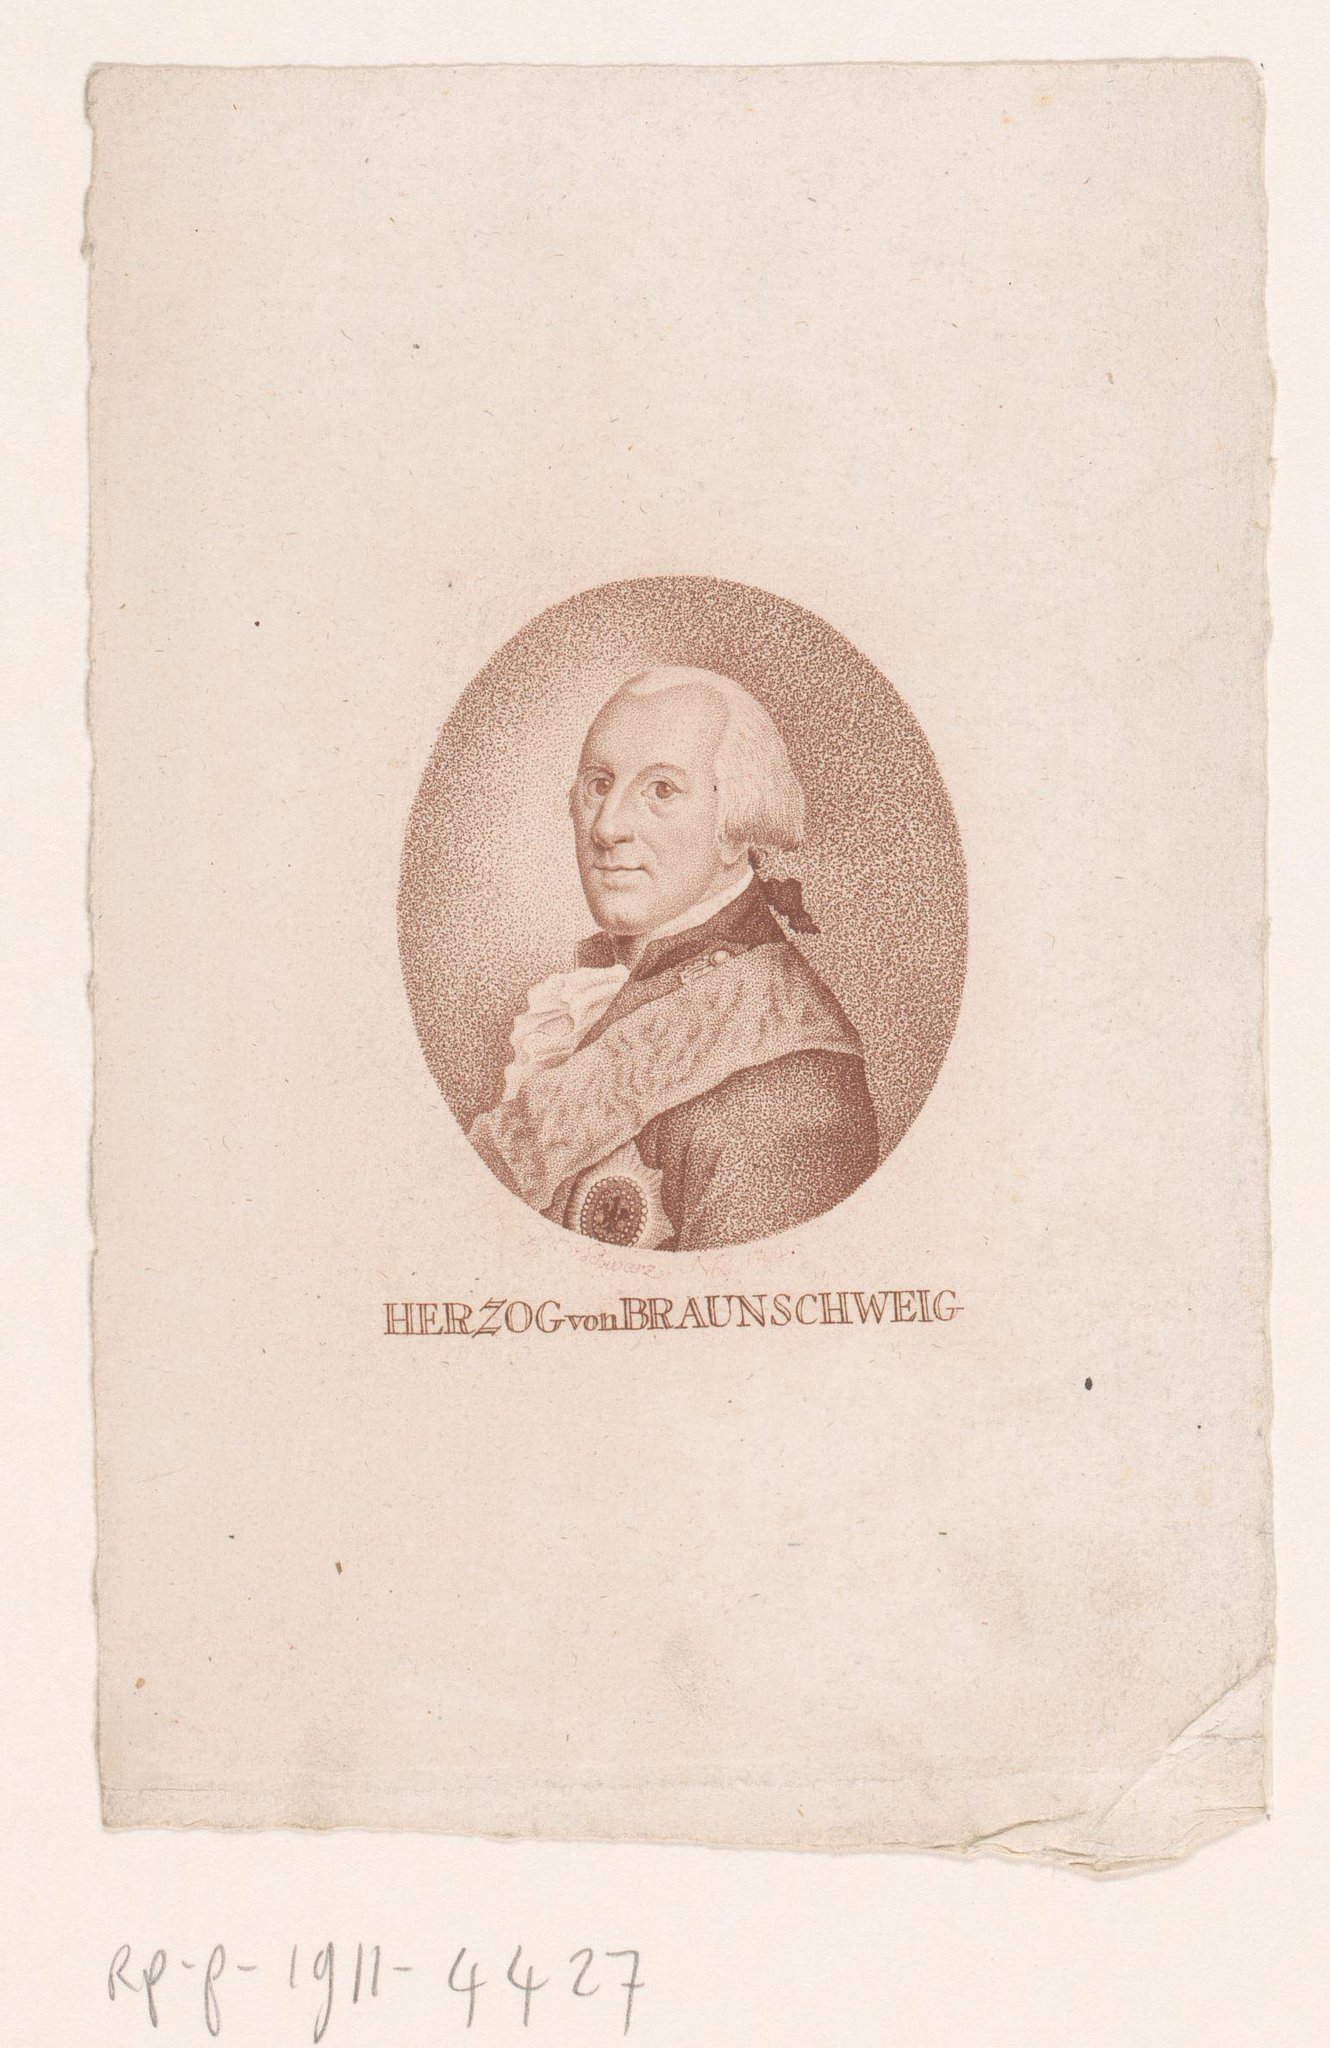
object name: print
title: Portret van Karel Willem Ferdinand, hertog van Brunswijk-Wolfenbüttel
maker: paul wolfgang schwarz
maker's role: print maker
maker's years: -1815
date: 1794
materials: paper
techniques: engraving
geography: nuremberg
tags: knighthood order (with name) - insignia of a knighthood order, e.g.: badge, chain (with name of order), historical persons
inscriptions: collector's mark: Lugt 2228